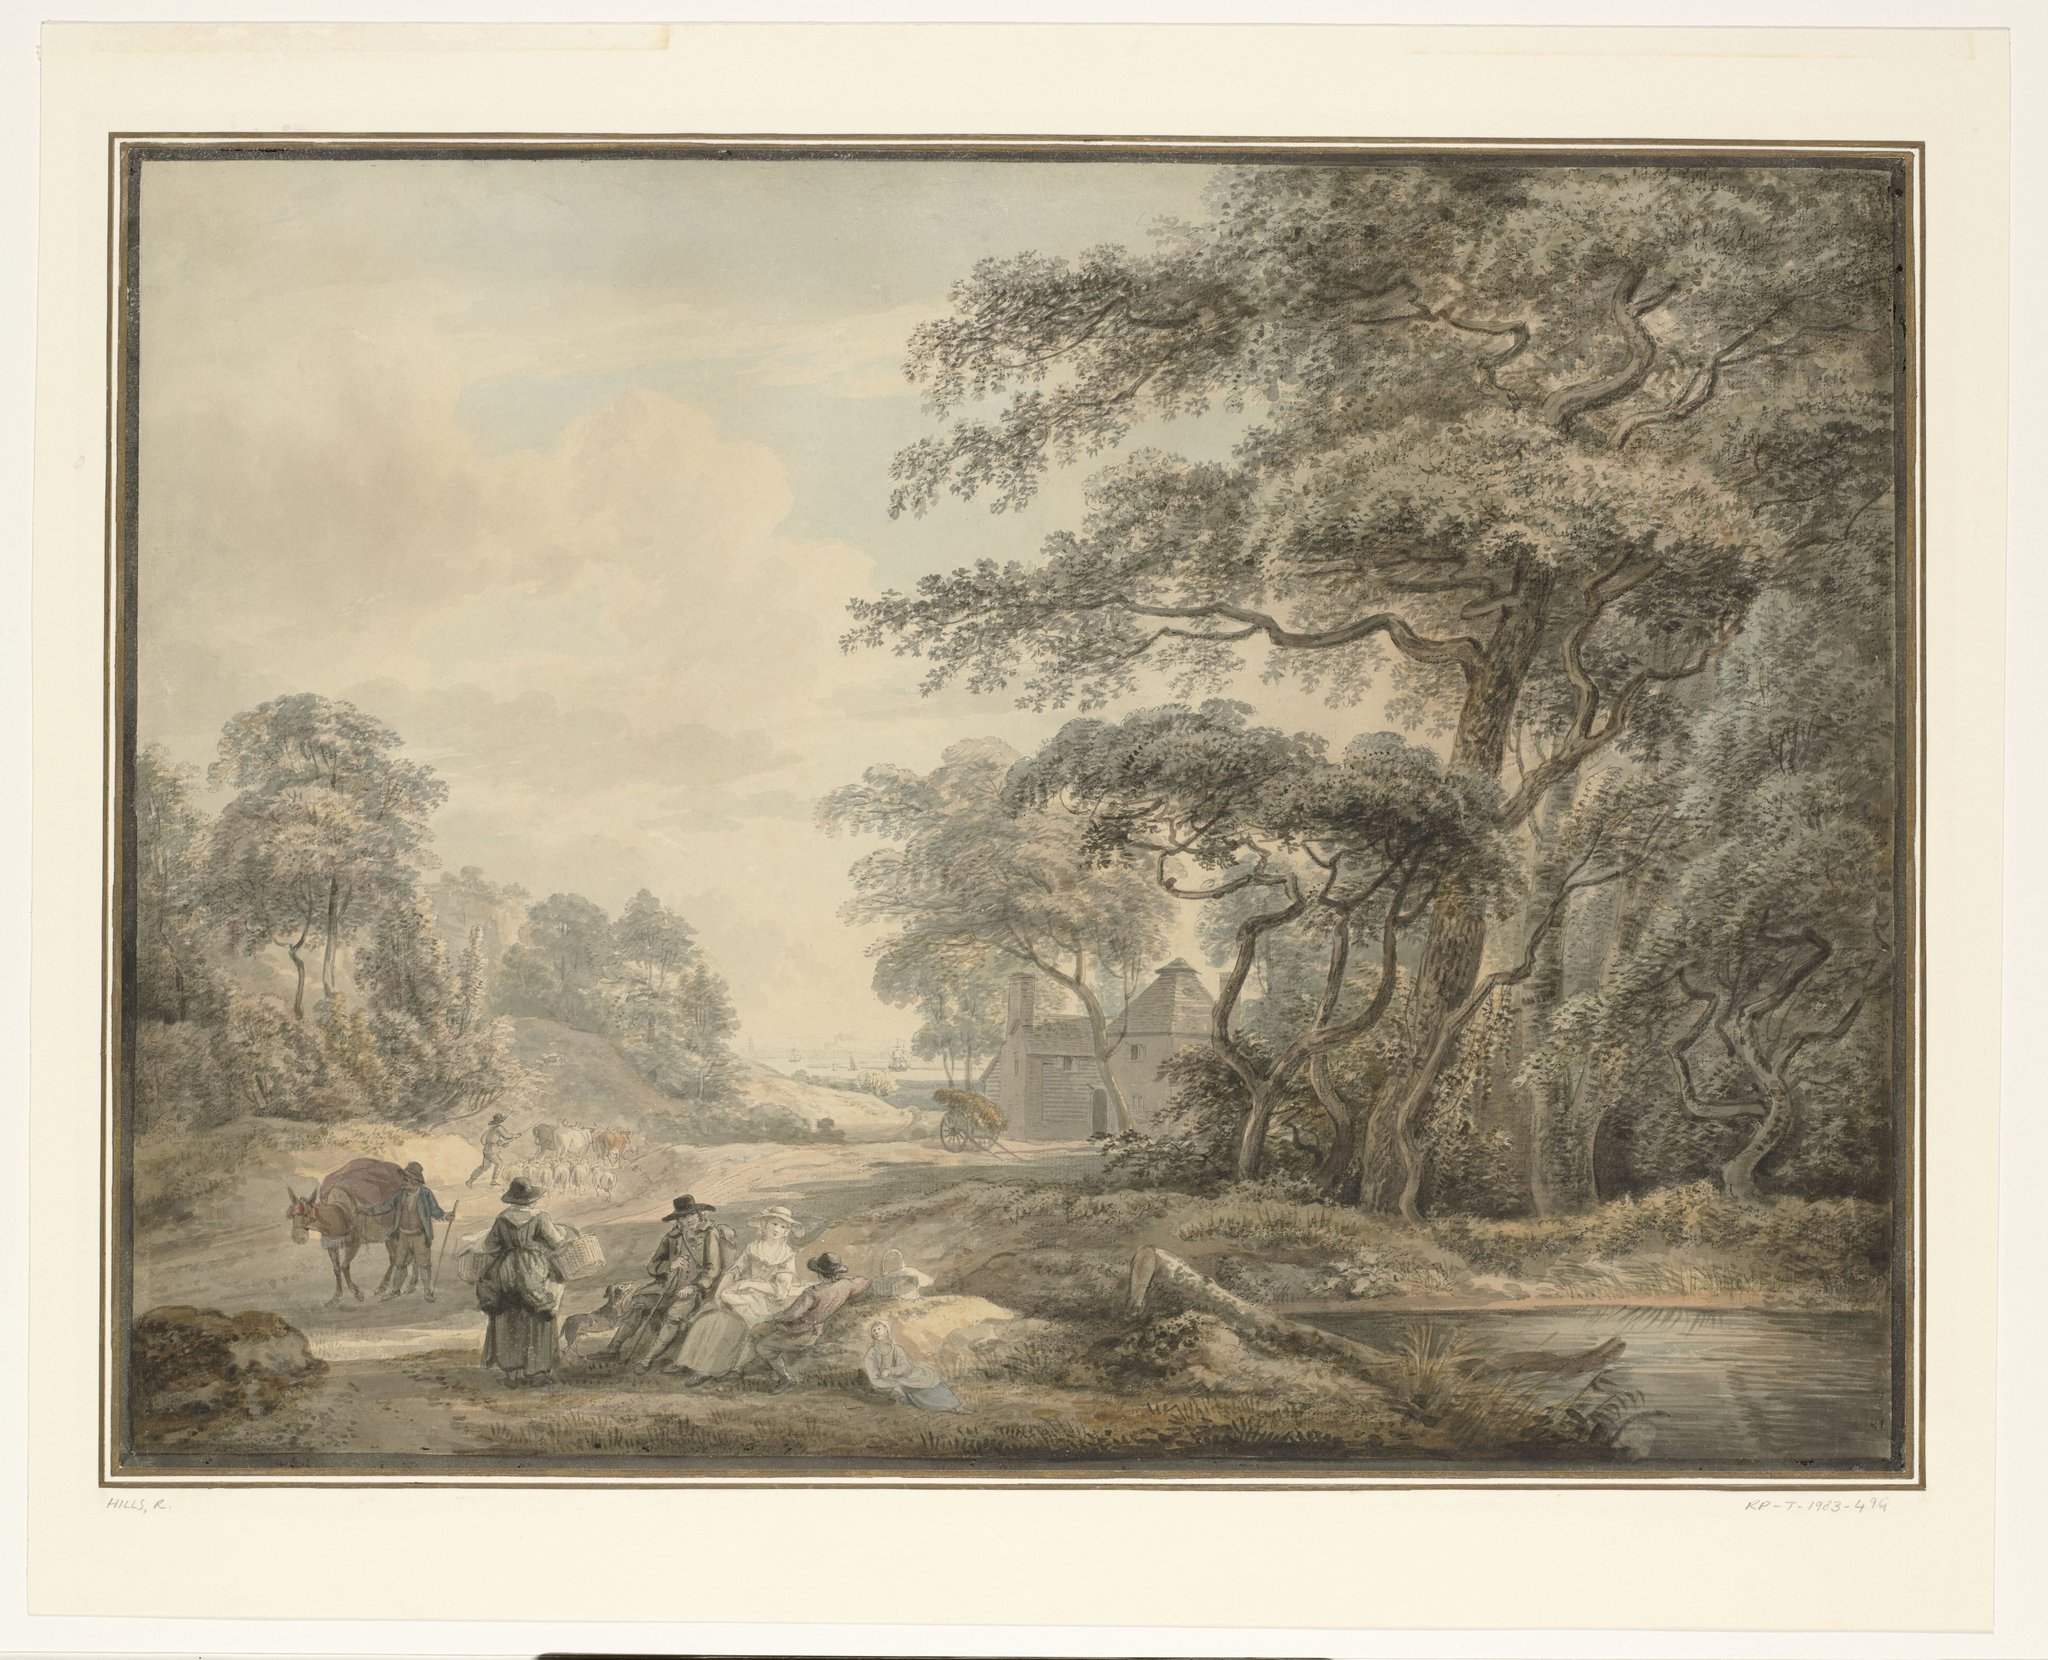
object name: drawing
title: Travellers Halted in a Wooded Landscape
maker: paul sandby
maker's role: draughtsman, print maker, publisher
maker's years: 1725-1809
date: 1735-1809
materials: chalk, paper, watercolor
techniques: brush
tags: (traveller) resting in the open air, woolwich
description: With his balanced landscape compositions and crisply drawn figures, Sandby was a source of inspiration for artists such as William Turner and Michael Rooker. Between 1770 and 1800 Sandby produced many watercolours, like this one, that were meant to be framed and displayed. He had to pay for their framing himself. This became a burden, and so he turned to painting in oil after 1800.